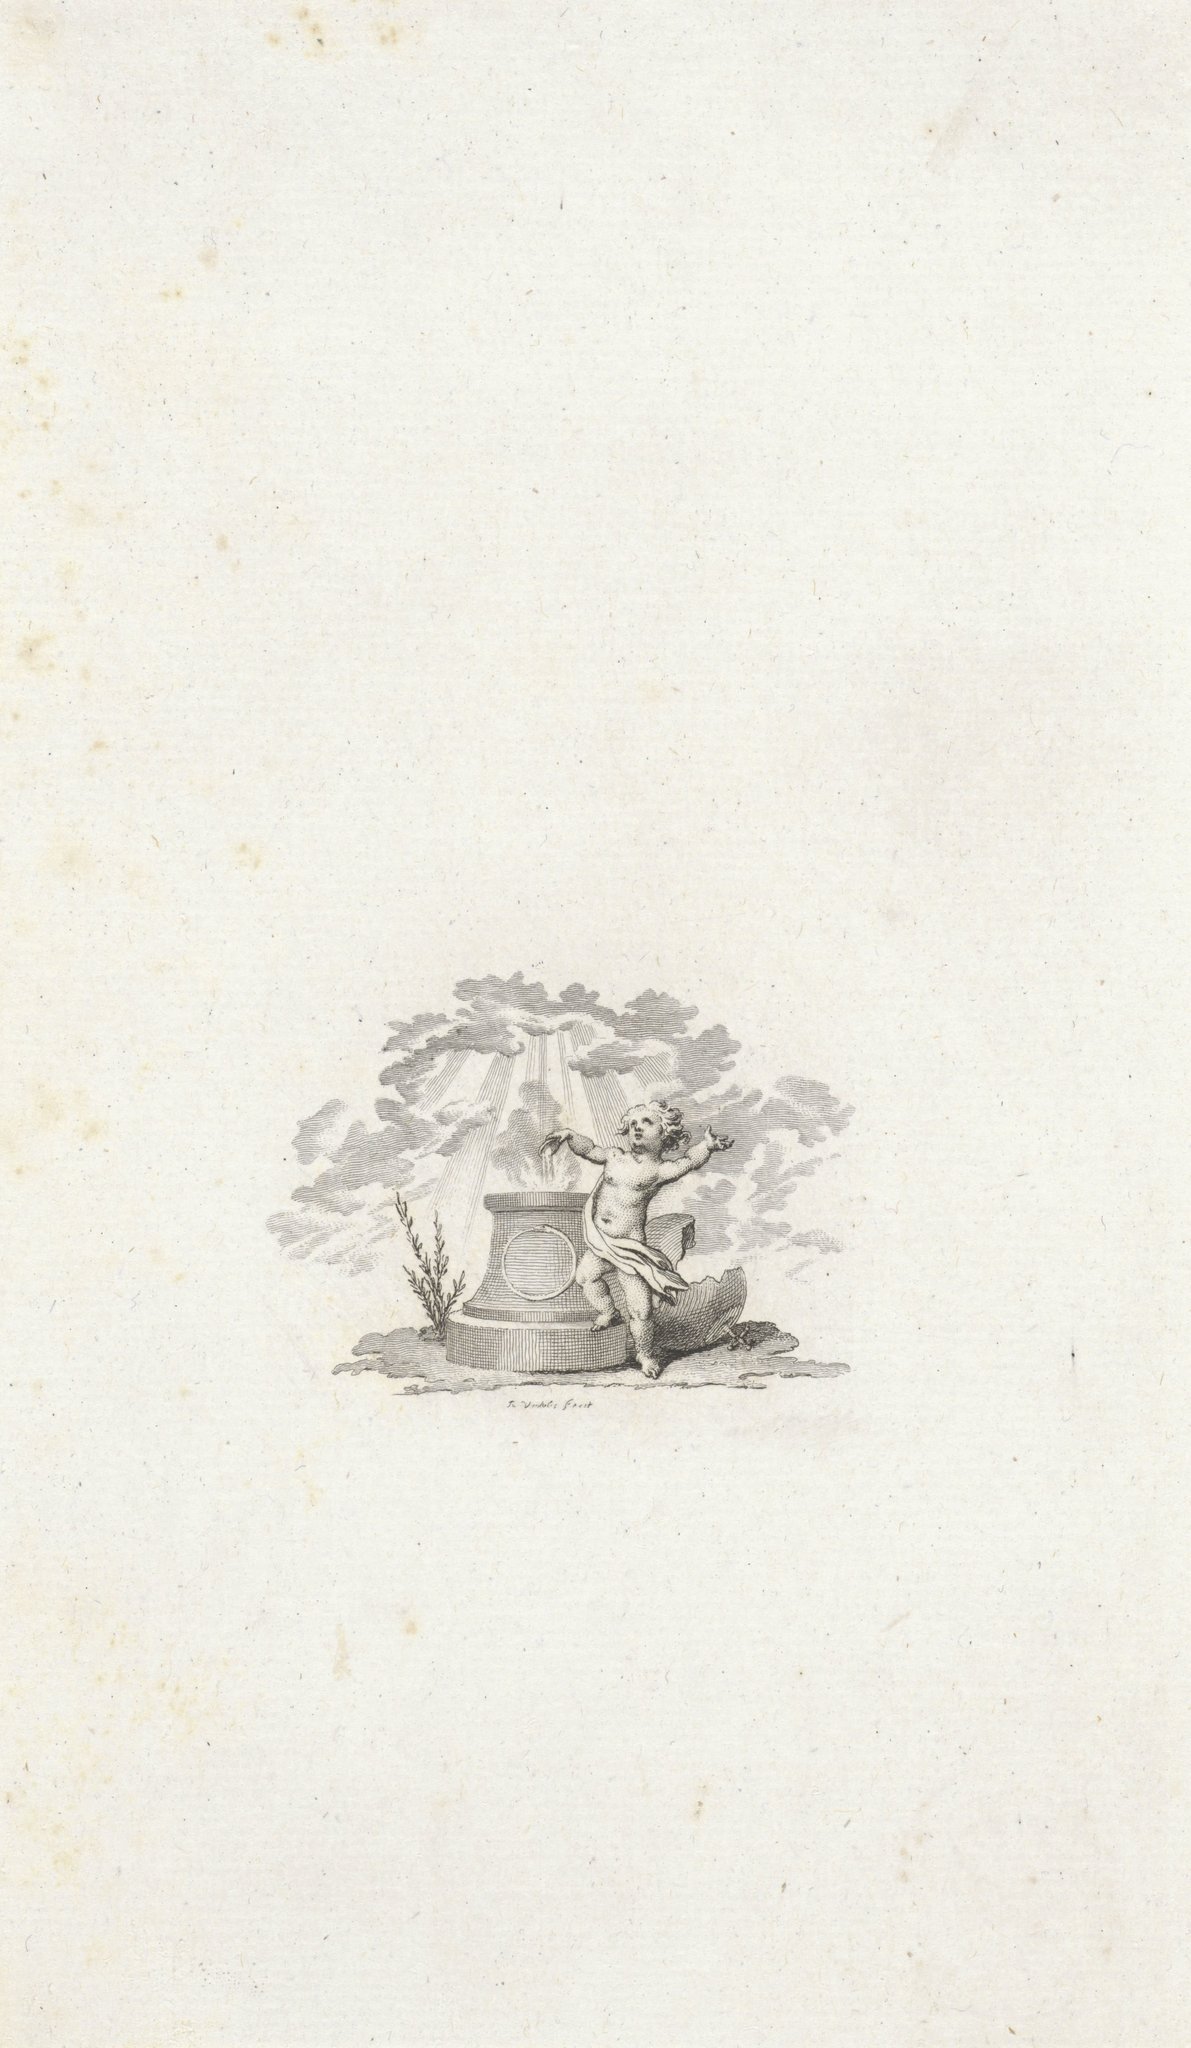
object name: print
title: Vignet met een putto bij een altaar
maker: reinier vinkeles (i)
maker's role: draughtsman, print maker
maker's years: 1741-1816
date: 1751-1816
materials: paper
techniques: engraving, etching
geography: amsterdam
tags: altar, cupids: 'amores', 'amoretti', 'putti'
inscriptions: collector's mark: Lugt 240